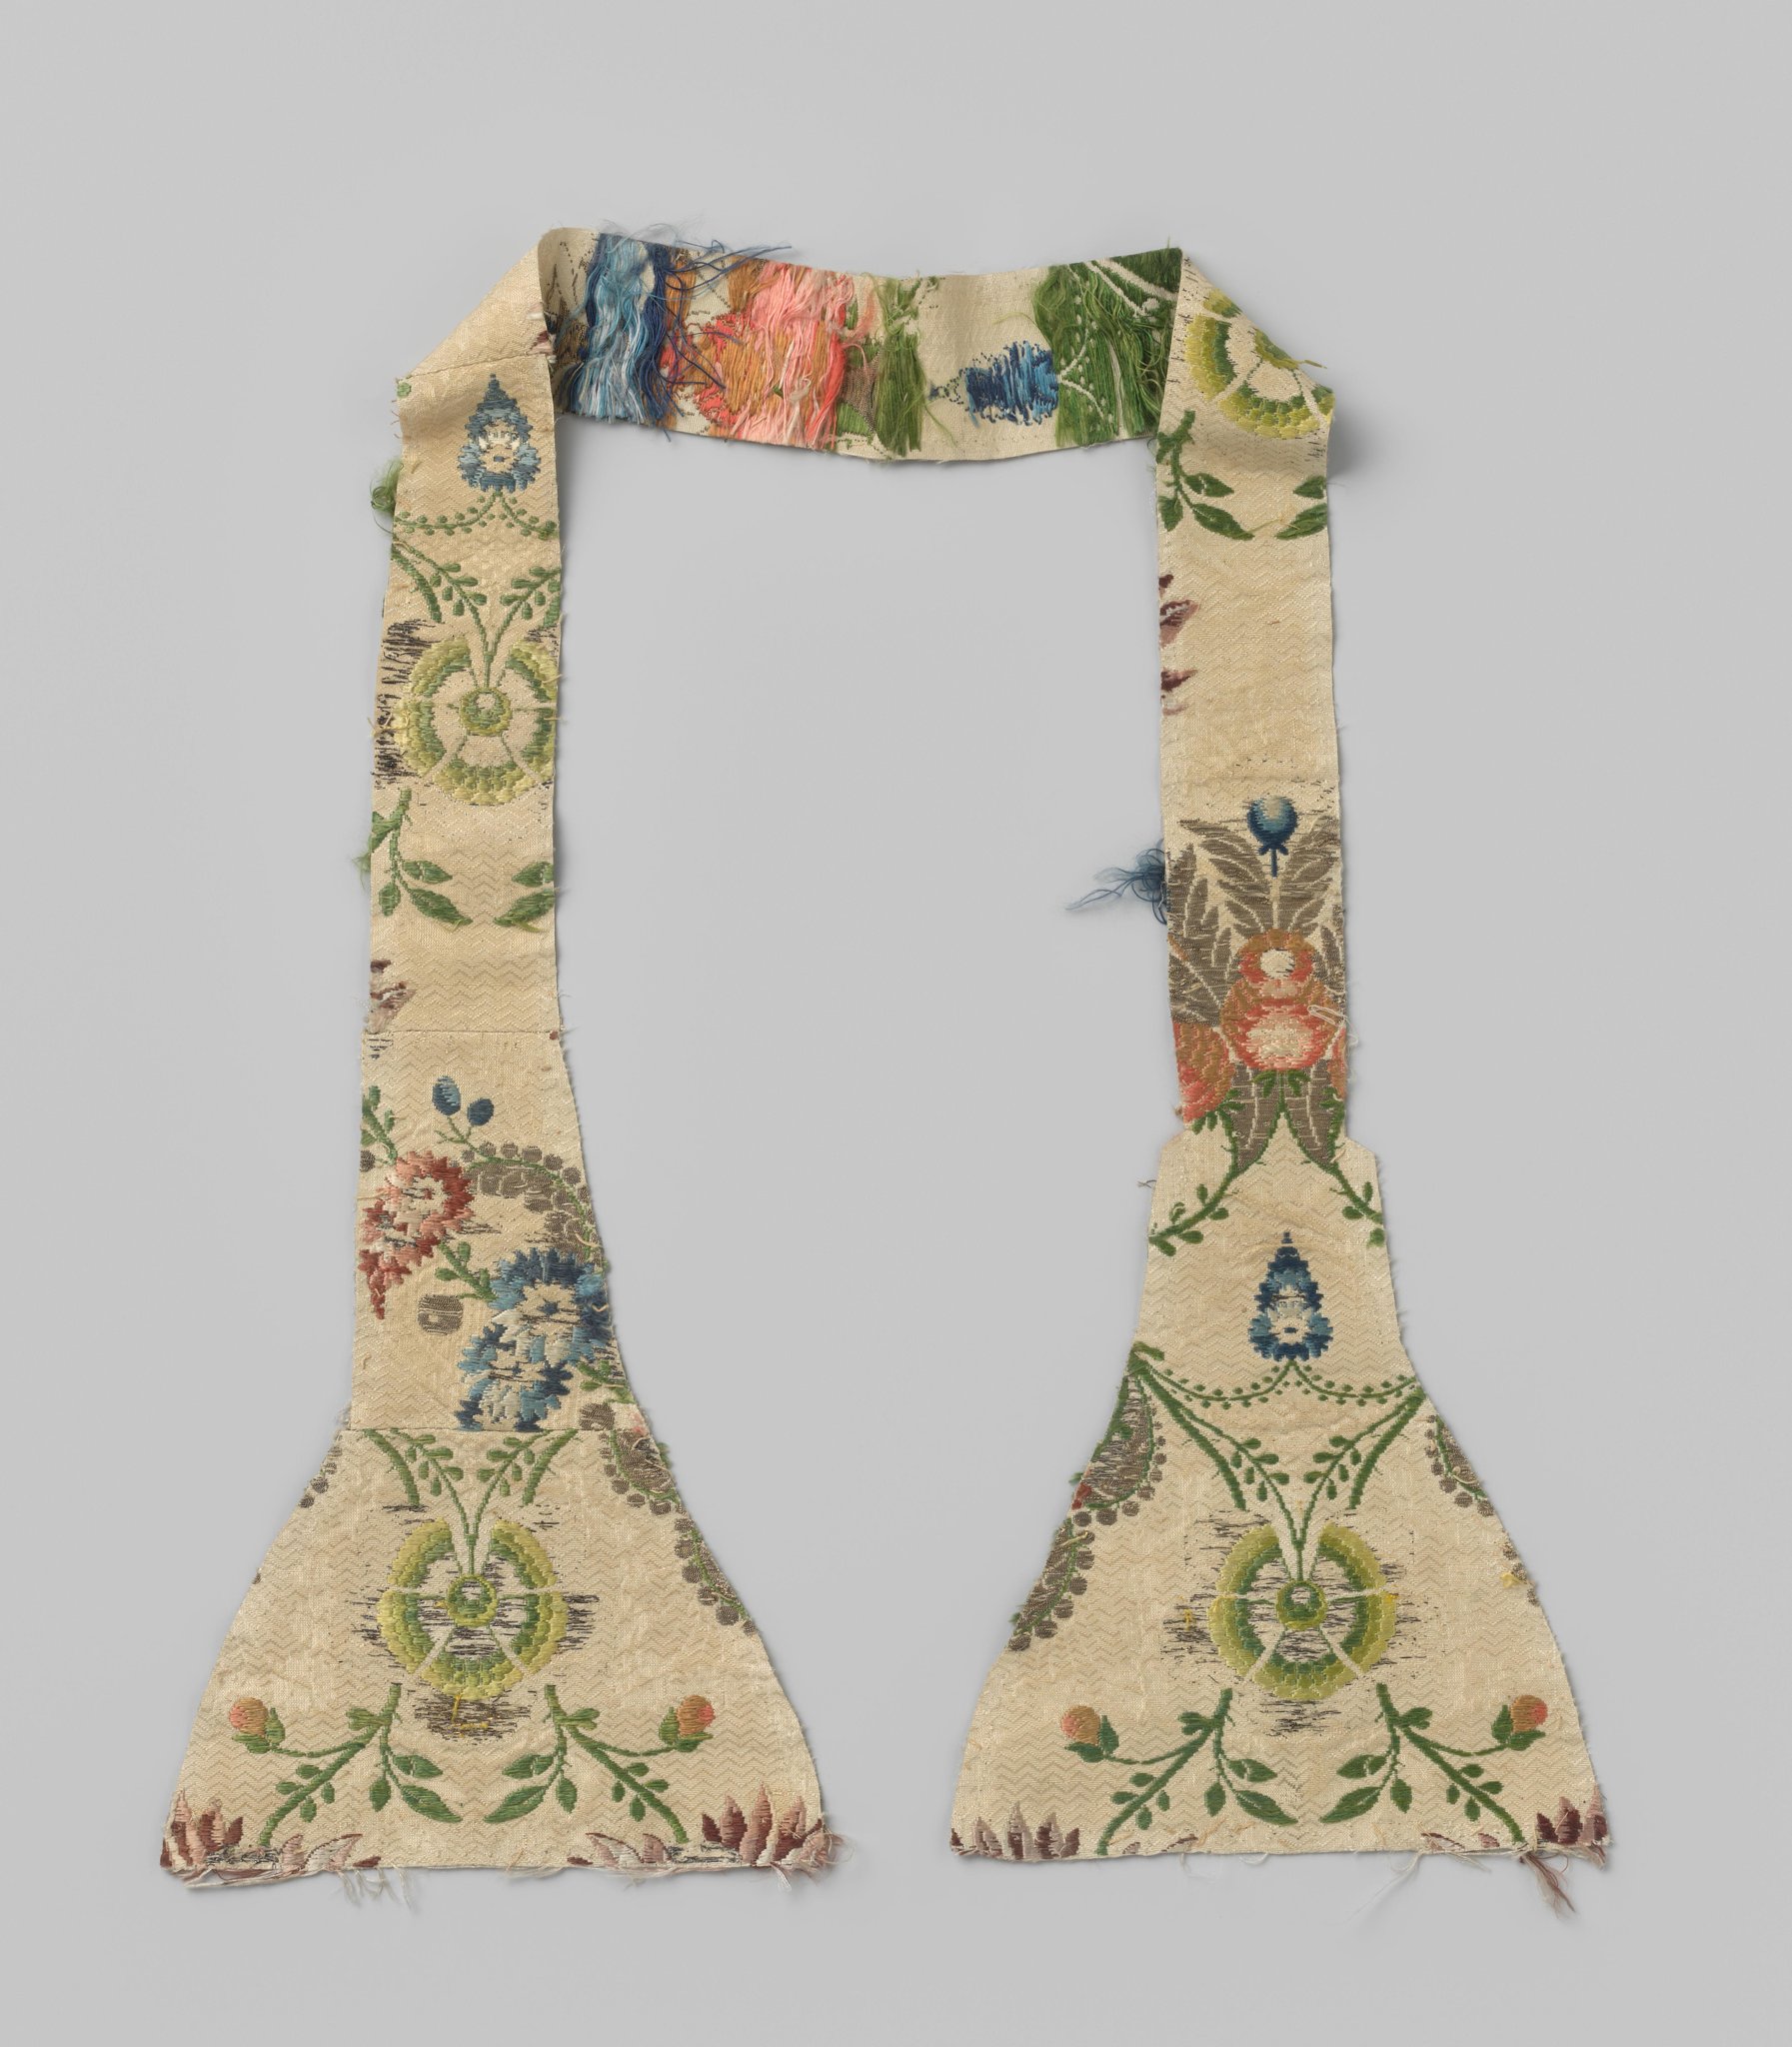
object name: maniple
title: Stukken witte zijde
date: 1725-1799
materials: silk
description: Manipel onderdeel van een set van stukken witte zijde met ingeweven bloemen van zijde en gouddraad gediend hebbende tot stola en manipel. De stola bestaat uit negentien stukken, de manipel uit vier stukken.